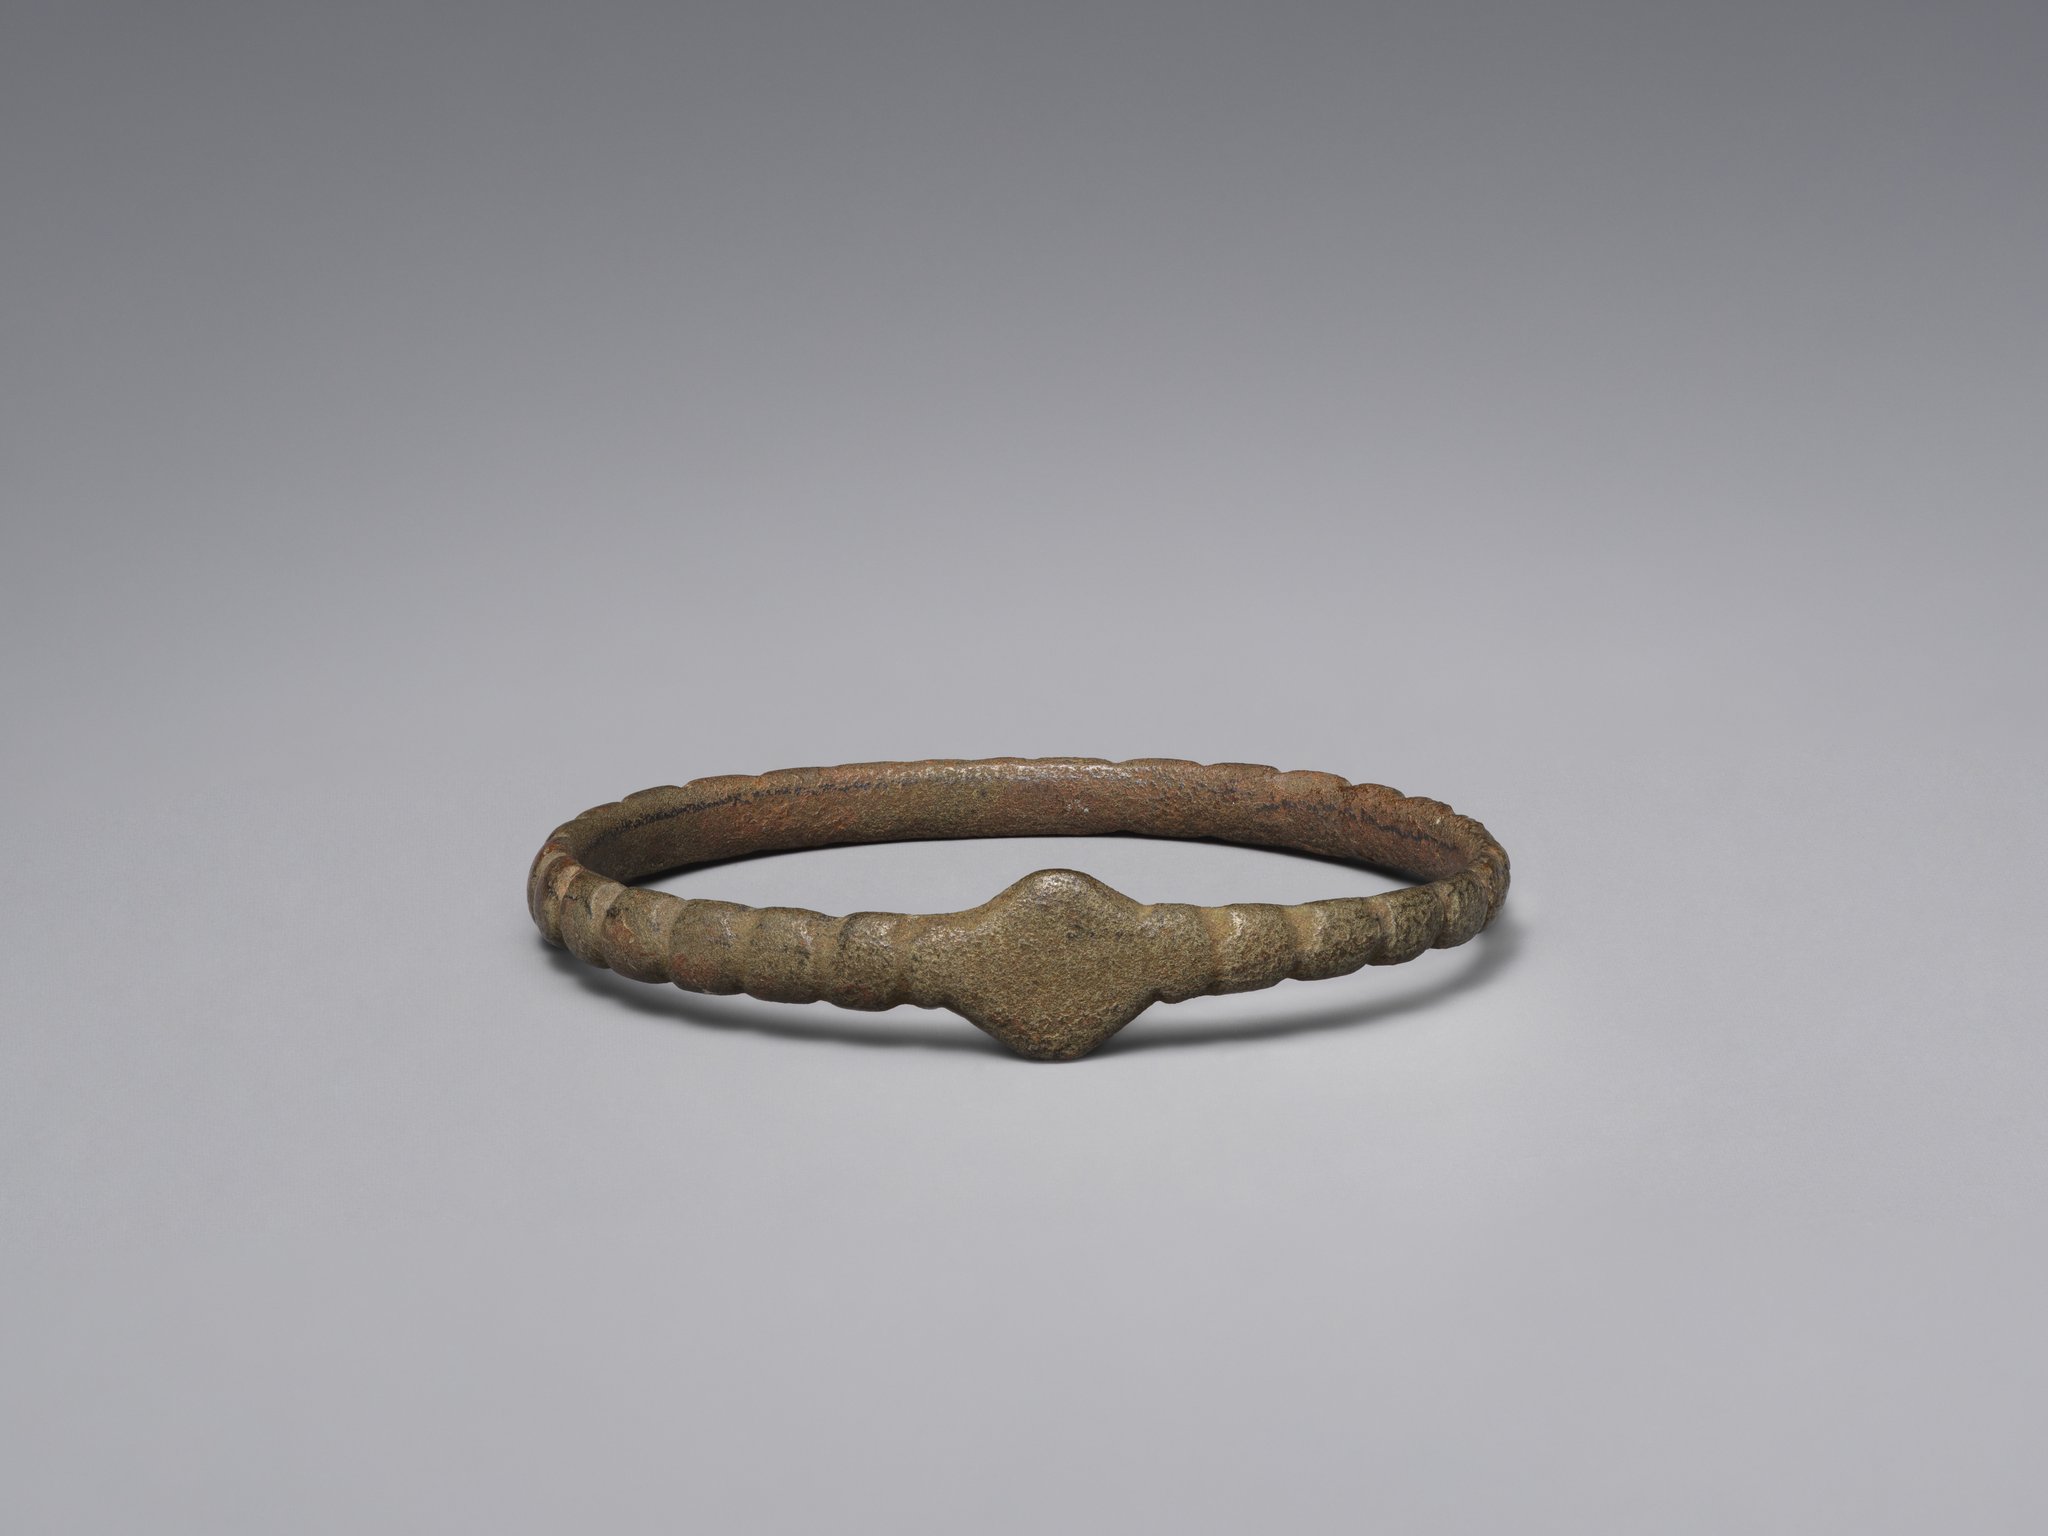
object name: bracelet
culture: sasanian or islamic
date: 501-800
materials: bronze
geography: iran